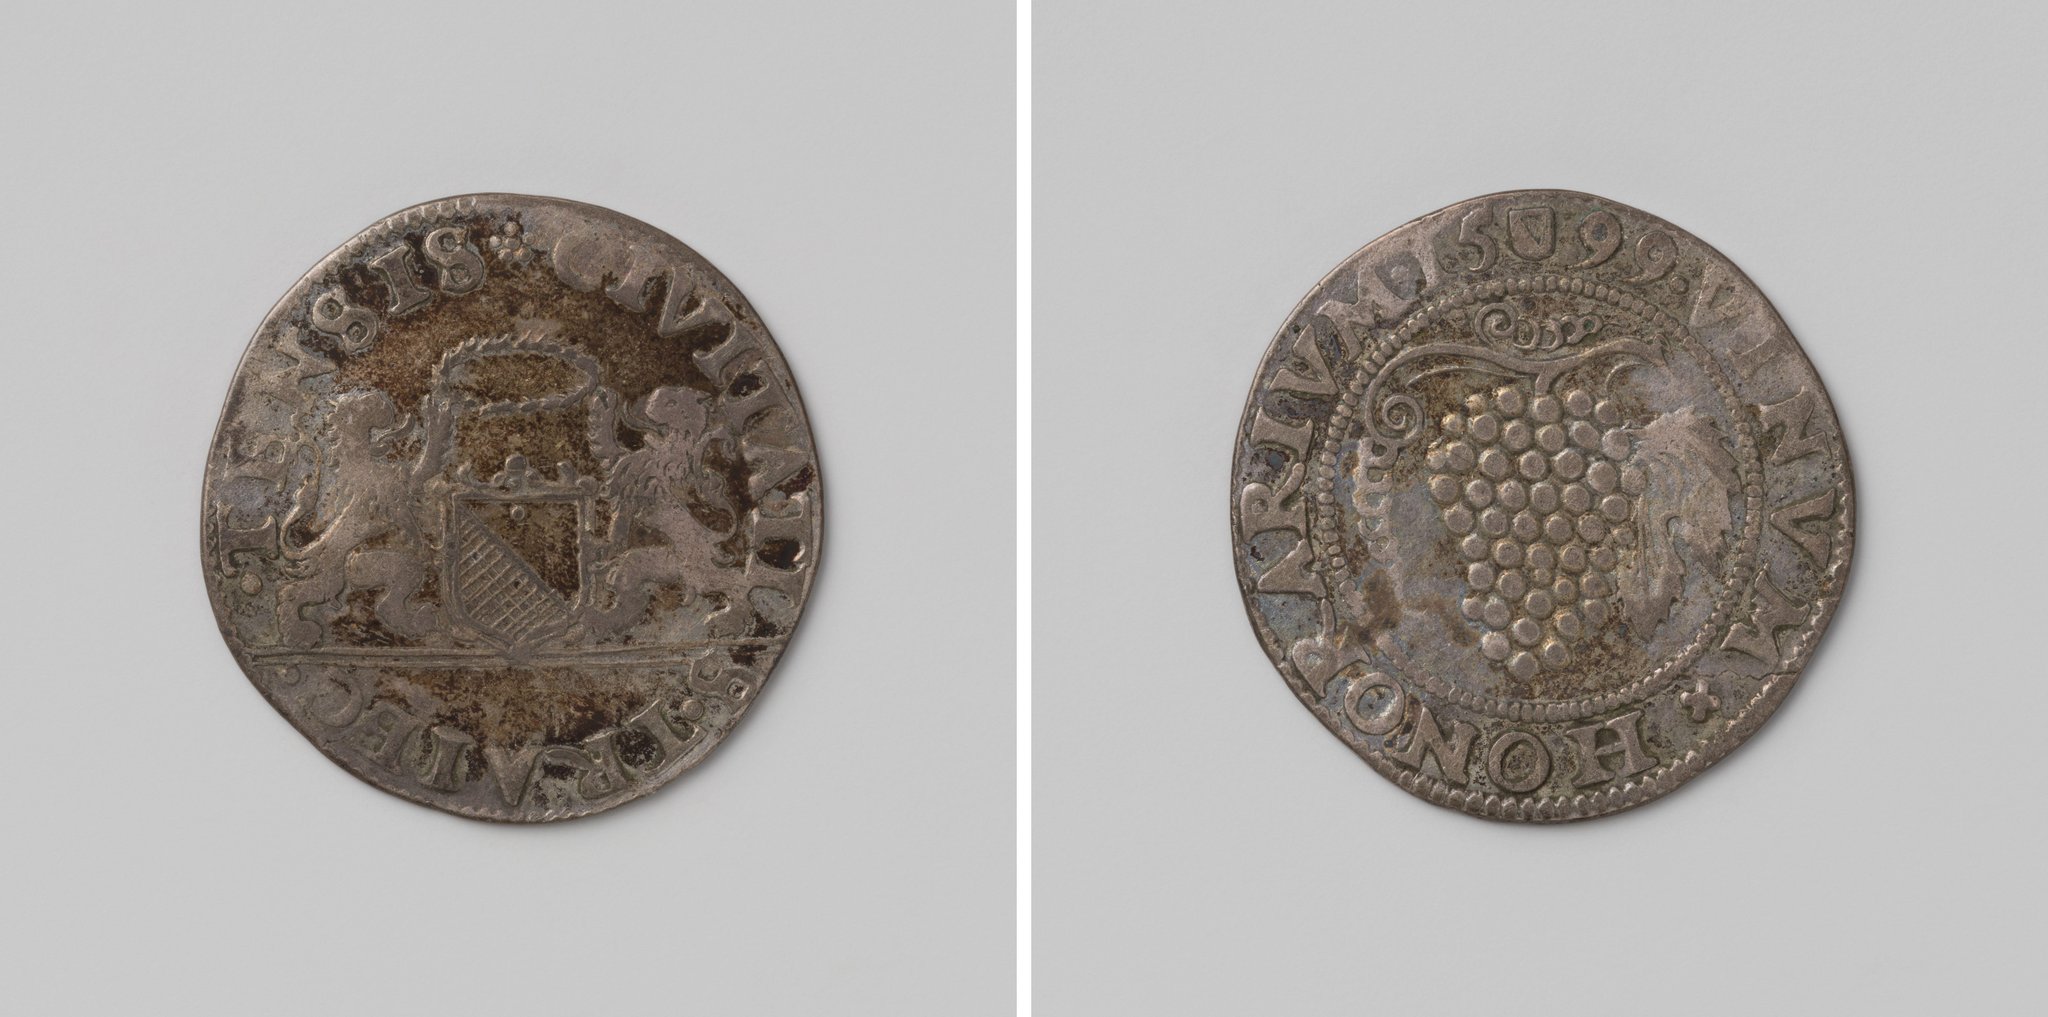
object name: marksman medal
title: Schutterij van Utrecht, penning die schutters recht gaf op een kan wijn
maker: Anonymous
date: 1599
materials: silver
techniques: striking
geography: utrecht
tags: utrecht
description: Zilveren wijn- en schutterspenning van Utrecht. Voorzijde: wapenschild, waarboven twee leeuwen lauwerkrans houden binnen omschrift. Keerzijde: tros druiven binnen omschrift